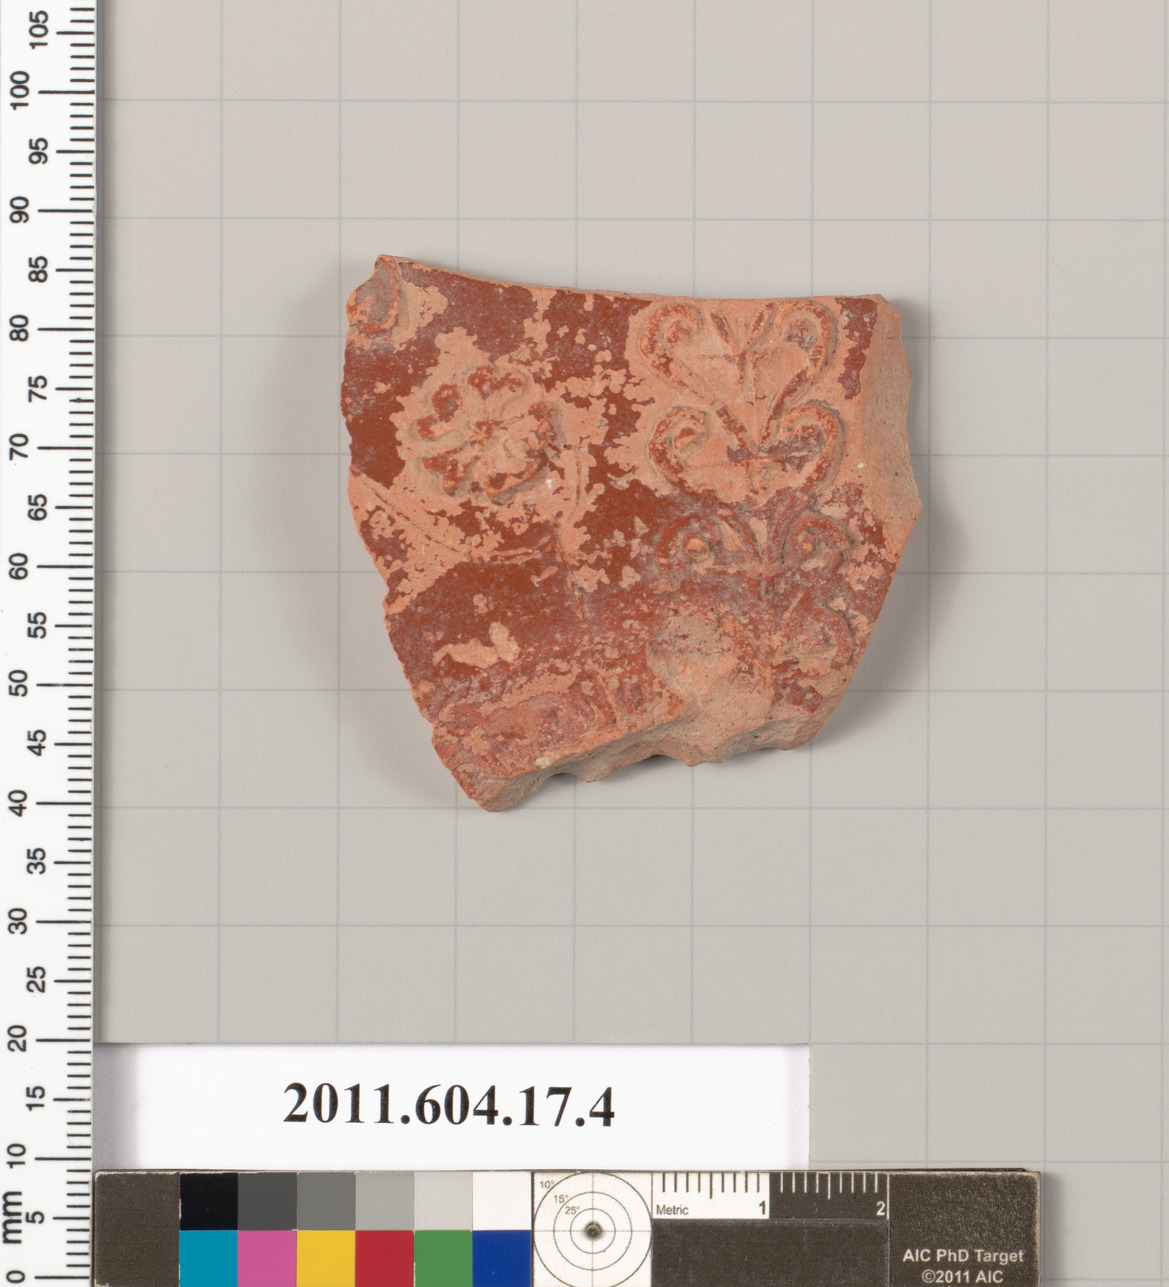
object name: fragment of a bowl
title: Terracotta rim fragment of a bowl?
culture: roman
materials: terracotta